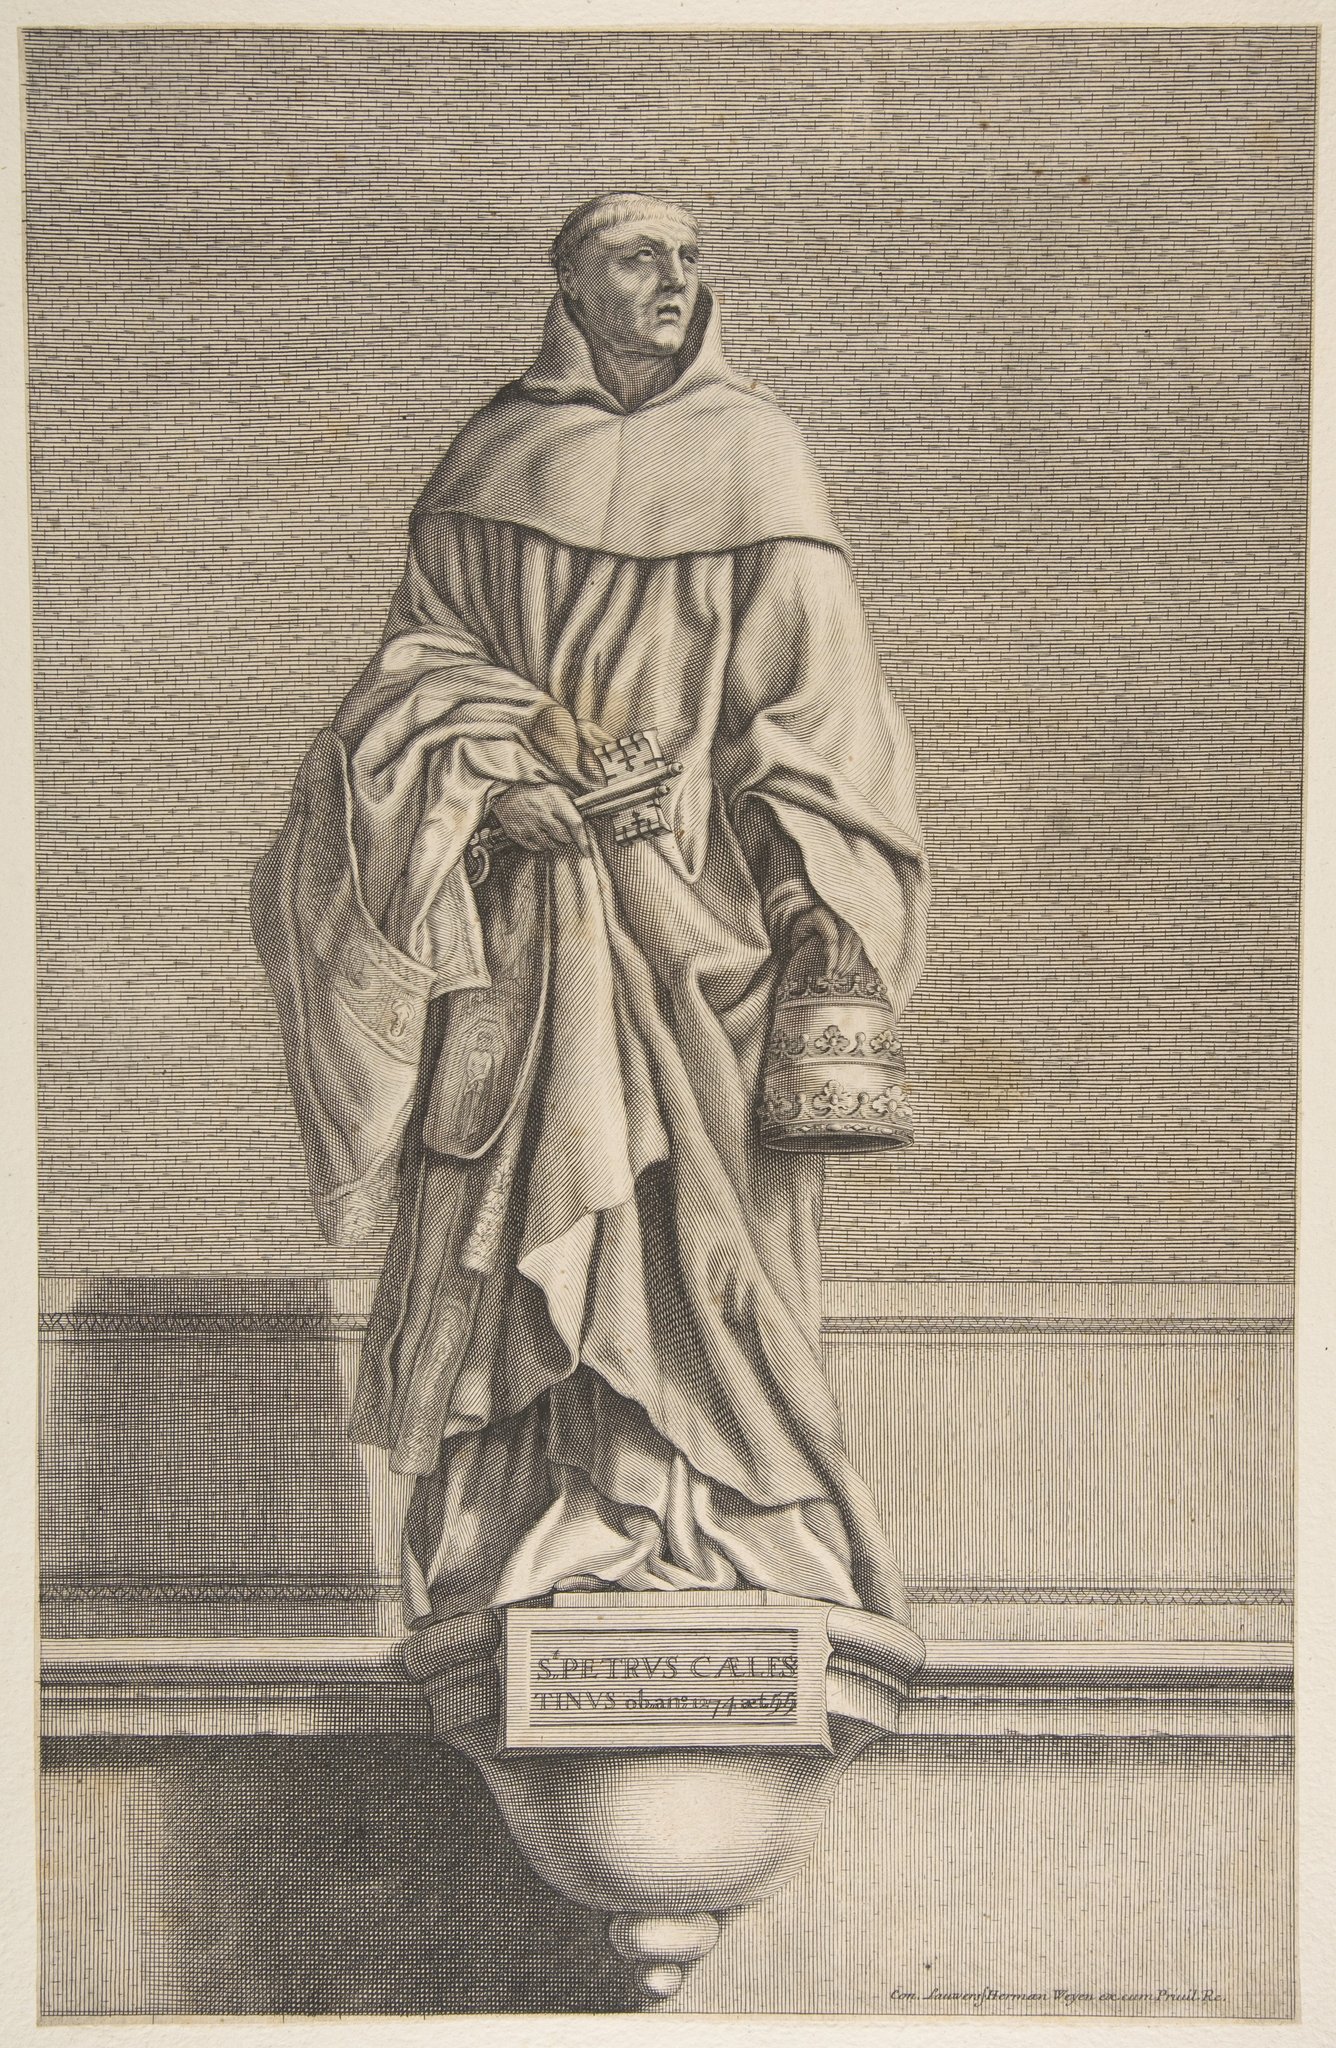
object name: print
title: St. Peter Celestine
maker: conrad lauwers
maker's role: artist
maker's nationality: flemish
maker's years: 1632-1685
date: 1632-1685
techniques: engraving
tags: saint peter